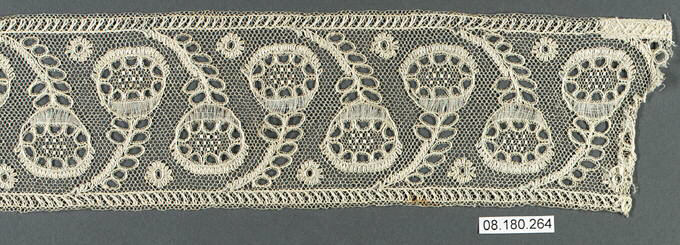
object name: insertion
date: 1701-1800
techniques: lace